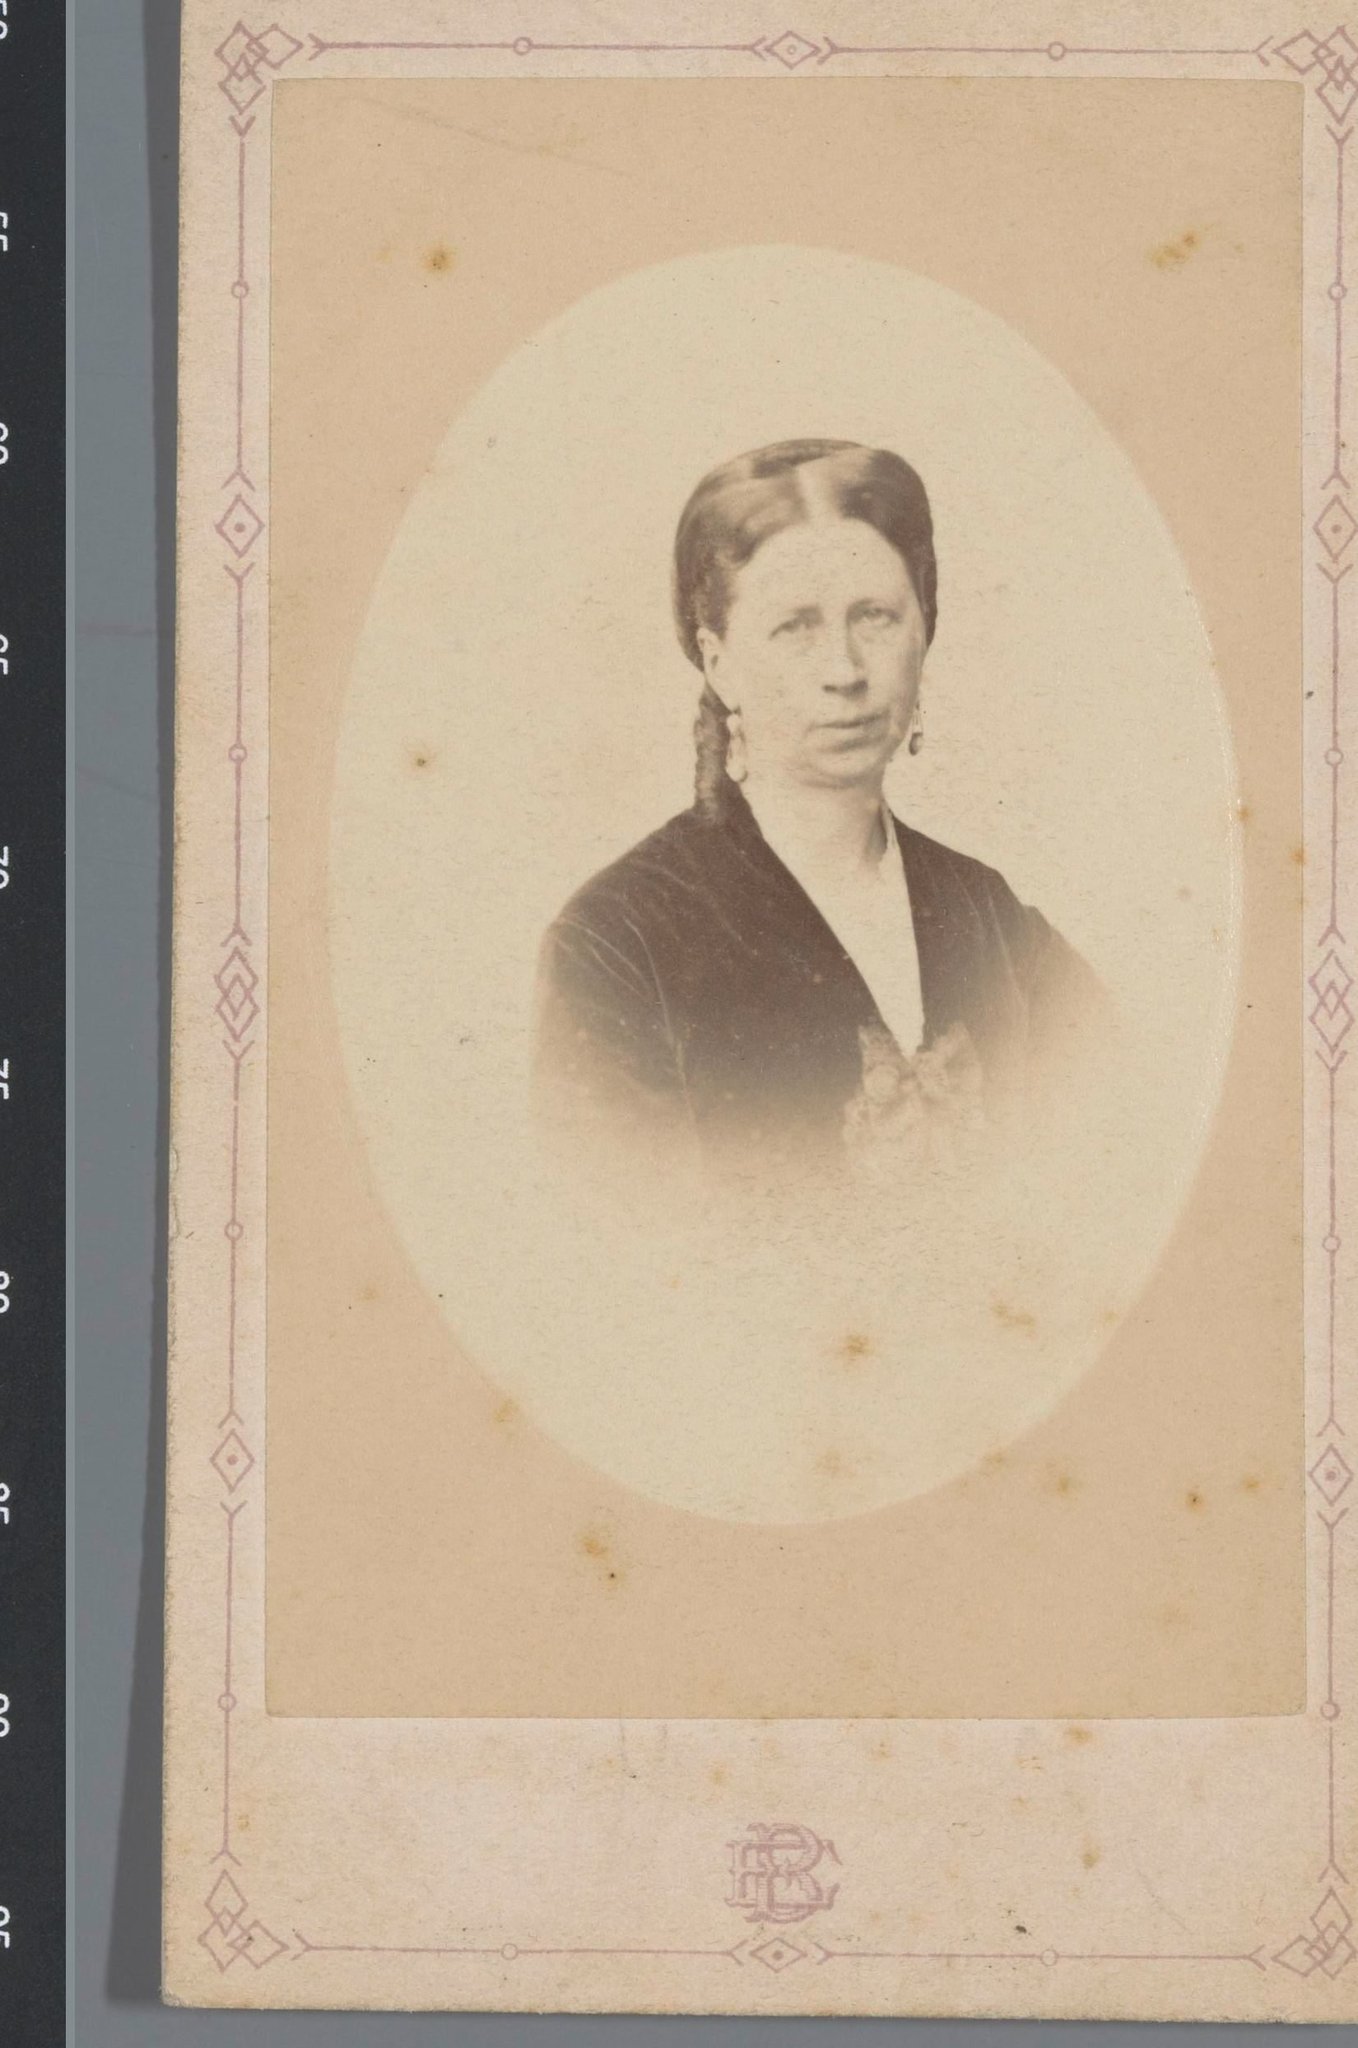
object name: carte de visite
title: Portret van een onbekende vrouw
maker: edmond bacot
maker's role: fotograaf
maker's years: 1814-1875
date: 1866-1875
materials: cardboard, paper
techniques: albumen print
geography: caen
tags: adult woman, anonymous historical person portrayed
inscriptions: inscription: ‘Paris 1855/ Mention Honorable/ Avranches/ 1854/ Caen/ 1861/ St. Lô/ 1866/ E. Bacot, 4. Rue de la Délivrande, Caen’, monogram: ‘EB’